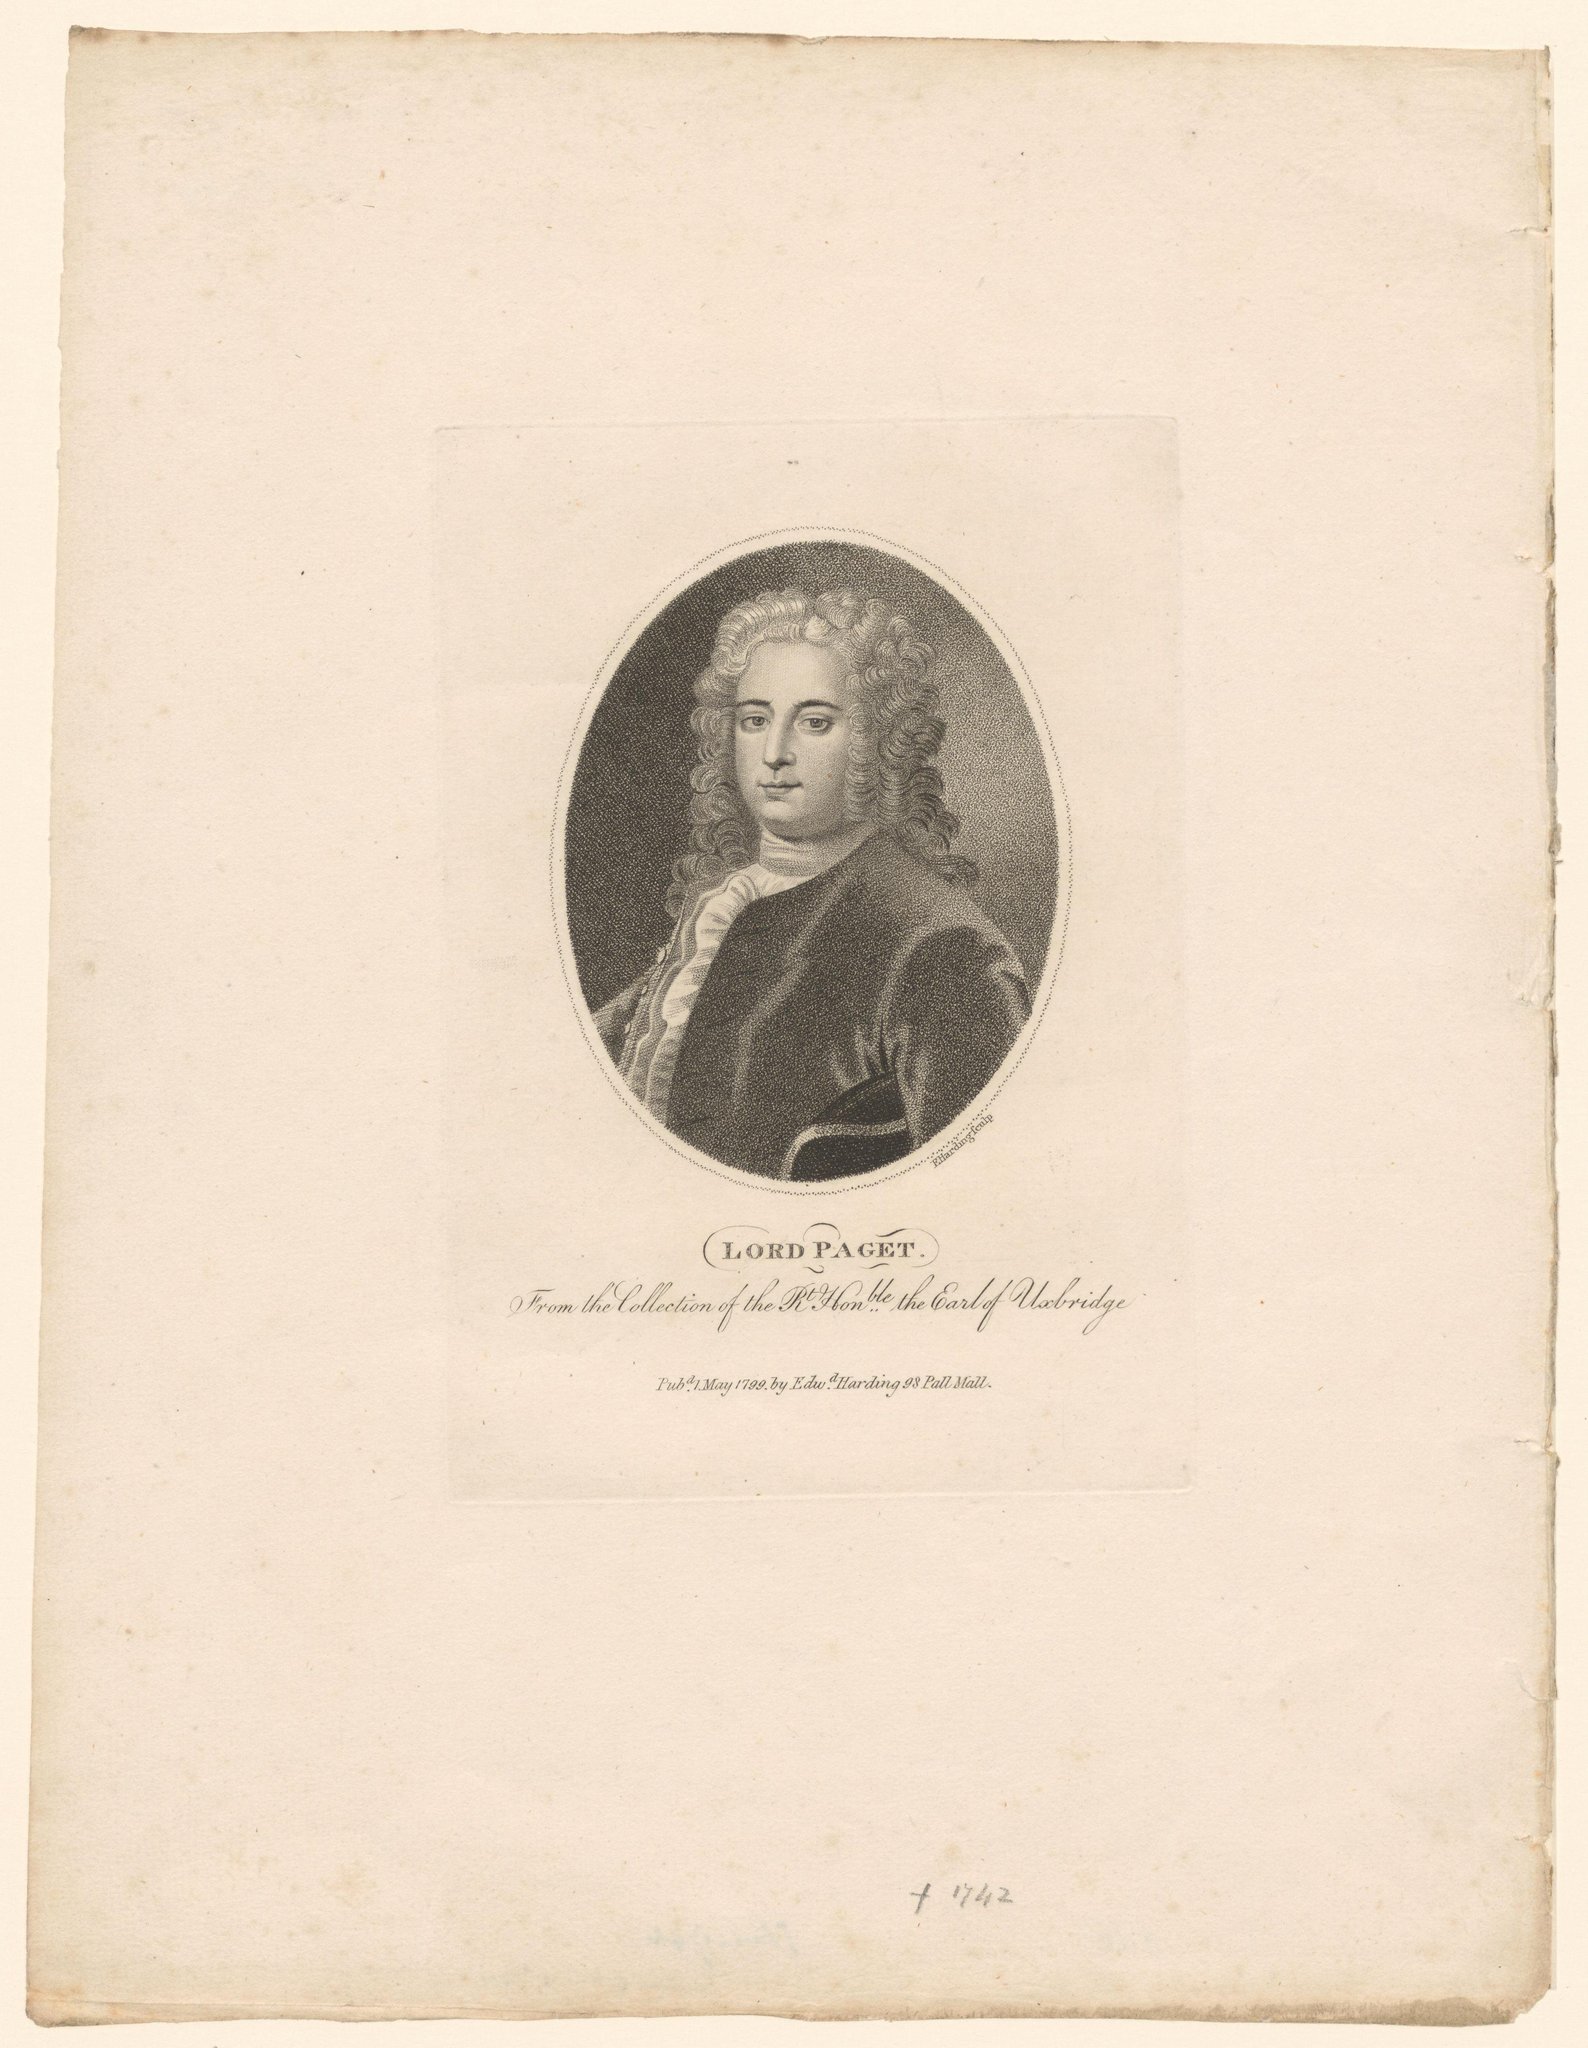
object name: book illustration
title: Portret van Thomas Catesby Paget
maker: edward harding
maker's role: print maker, publisher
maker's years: 1755-1840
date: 1799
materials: paper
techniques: etching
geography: london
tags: politician, historical persons, politician, e.g. party leader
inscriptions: inscription, collector's mark: Lugt 2228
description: Prent uit: Adolphus, John. The British Cabinet (...). Londen: Edward Harding, 1799.